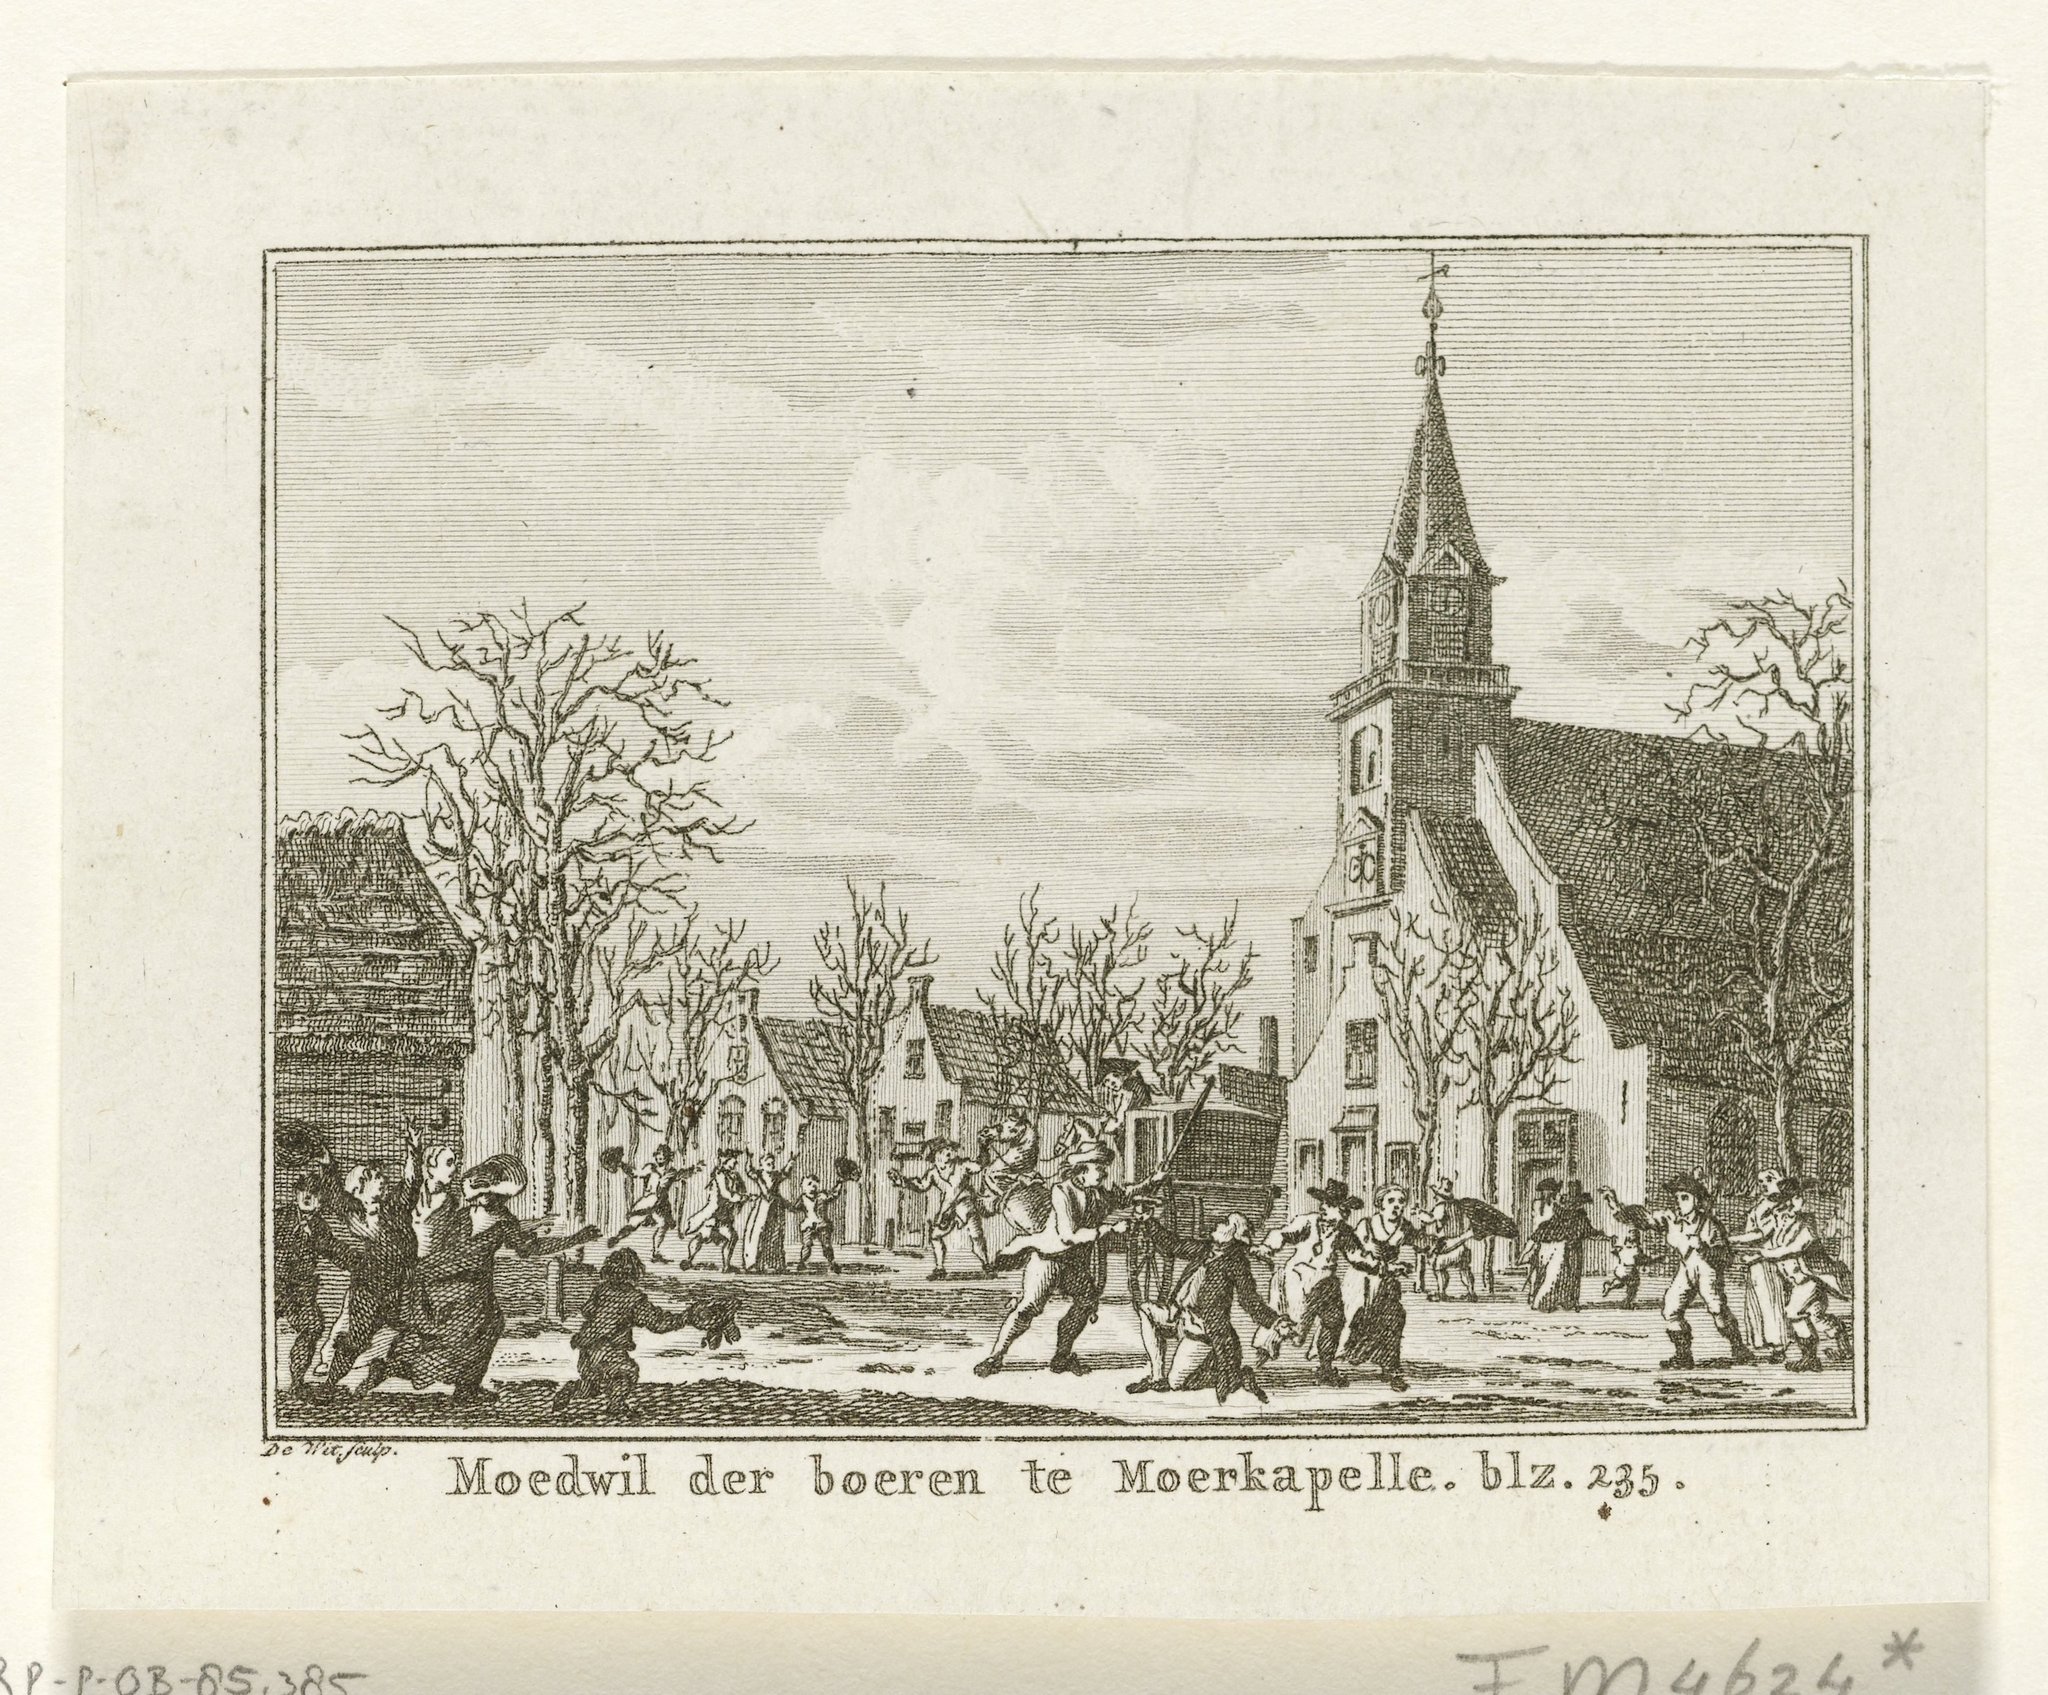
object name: print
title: Oproer te Moerkapelle, 1785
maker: izaak jansz. de wit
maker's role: draughtsman, print maker, publisher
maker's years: 1744-1809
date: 1785-1792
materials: paper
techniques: etching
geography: northern netherlands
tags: street-fights, riots, patriots (1780-1795)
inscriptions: collector's mark: Lugt 2228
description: Gebruikt als illustratie in: Cornelis Rogge. Beknopte historie der onlusten in de Nederlanden. : Sedert de onderhandelingen over de gewapende neutraliteit in 1780. 4 dln, Braband 1790-1792.